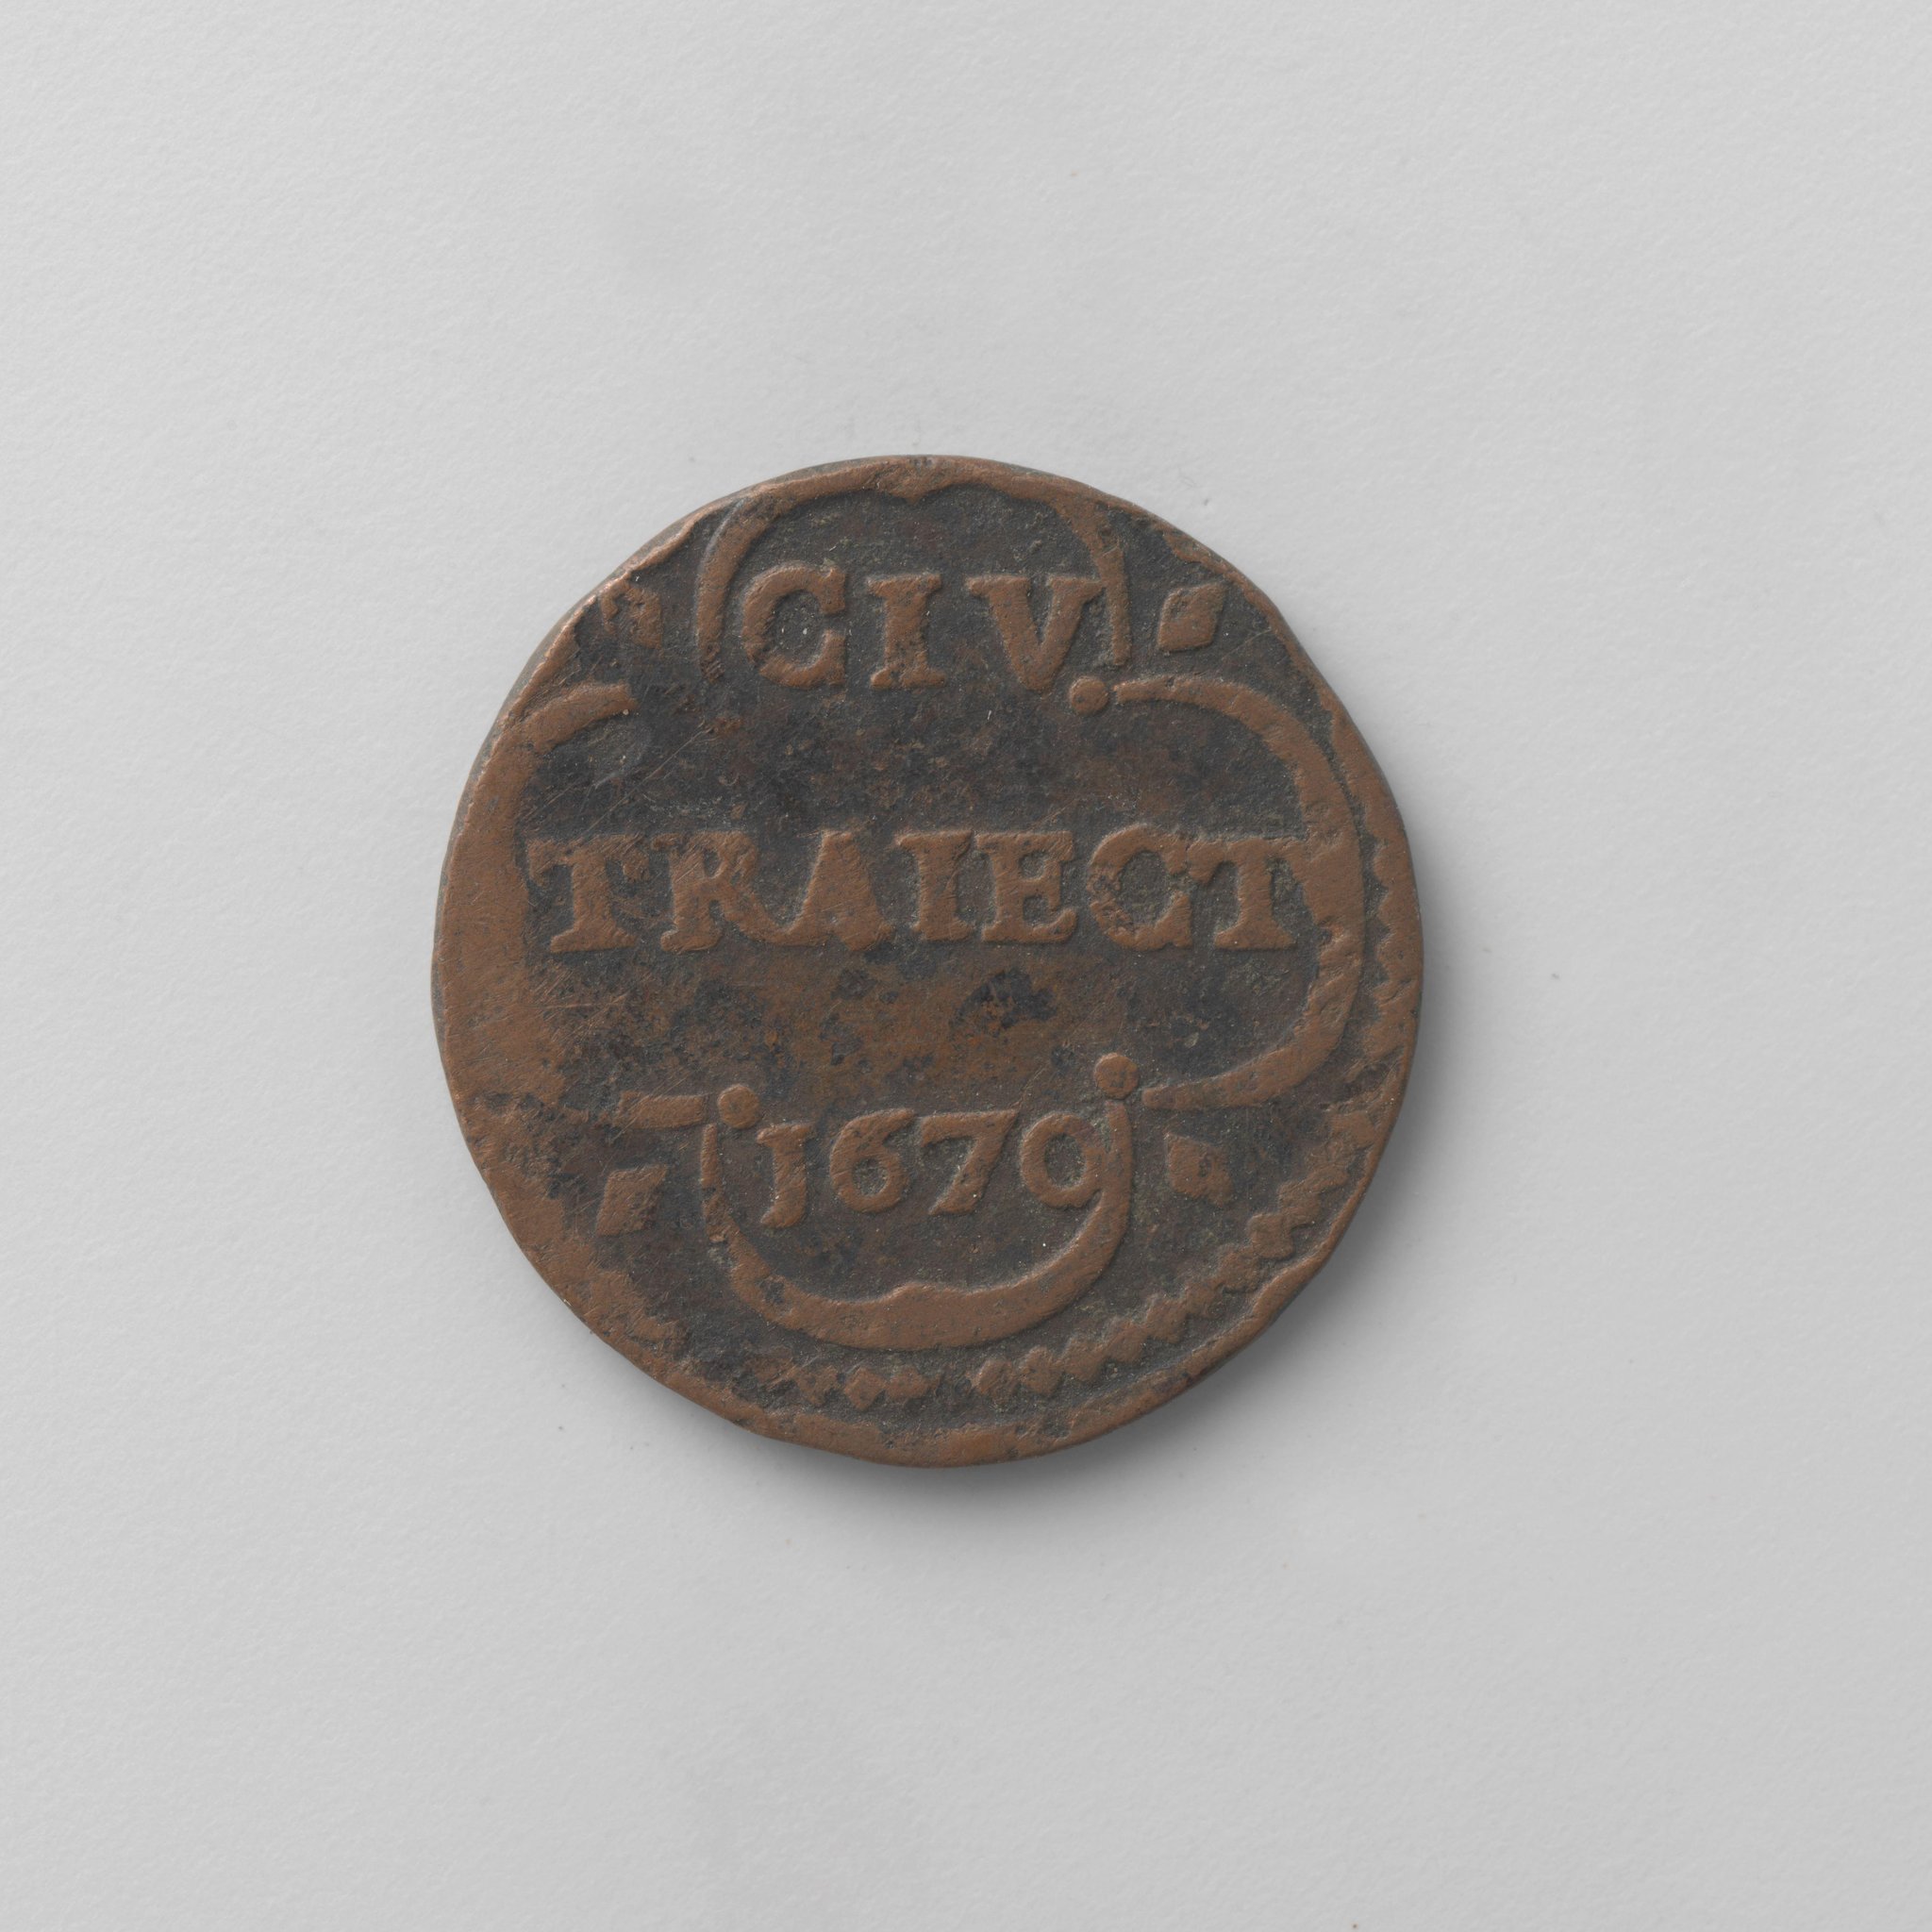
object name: coin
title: Duit van de stad Utrecht, 1670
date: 1670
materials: copper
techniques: striking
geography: utrecht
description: Koperen munt. Voorzijde: gekroond stedelijk, horizontaal gearceeerd wapenschild, gehouden door twee leeuwen. Keerzijde: binnen een versierde vierpas opschrift in twee regels, waaronder jaartal.